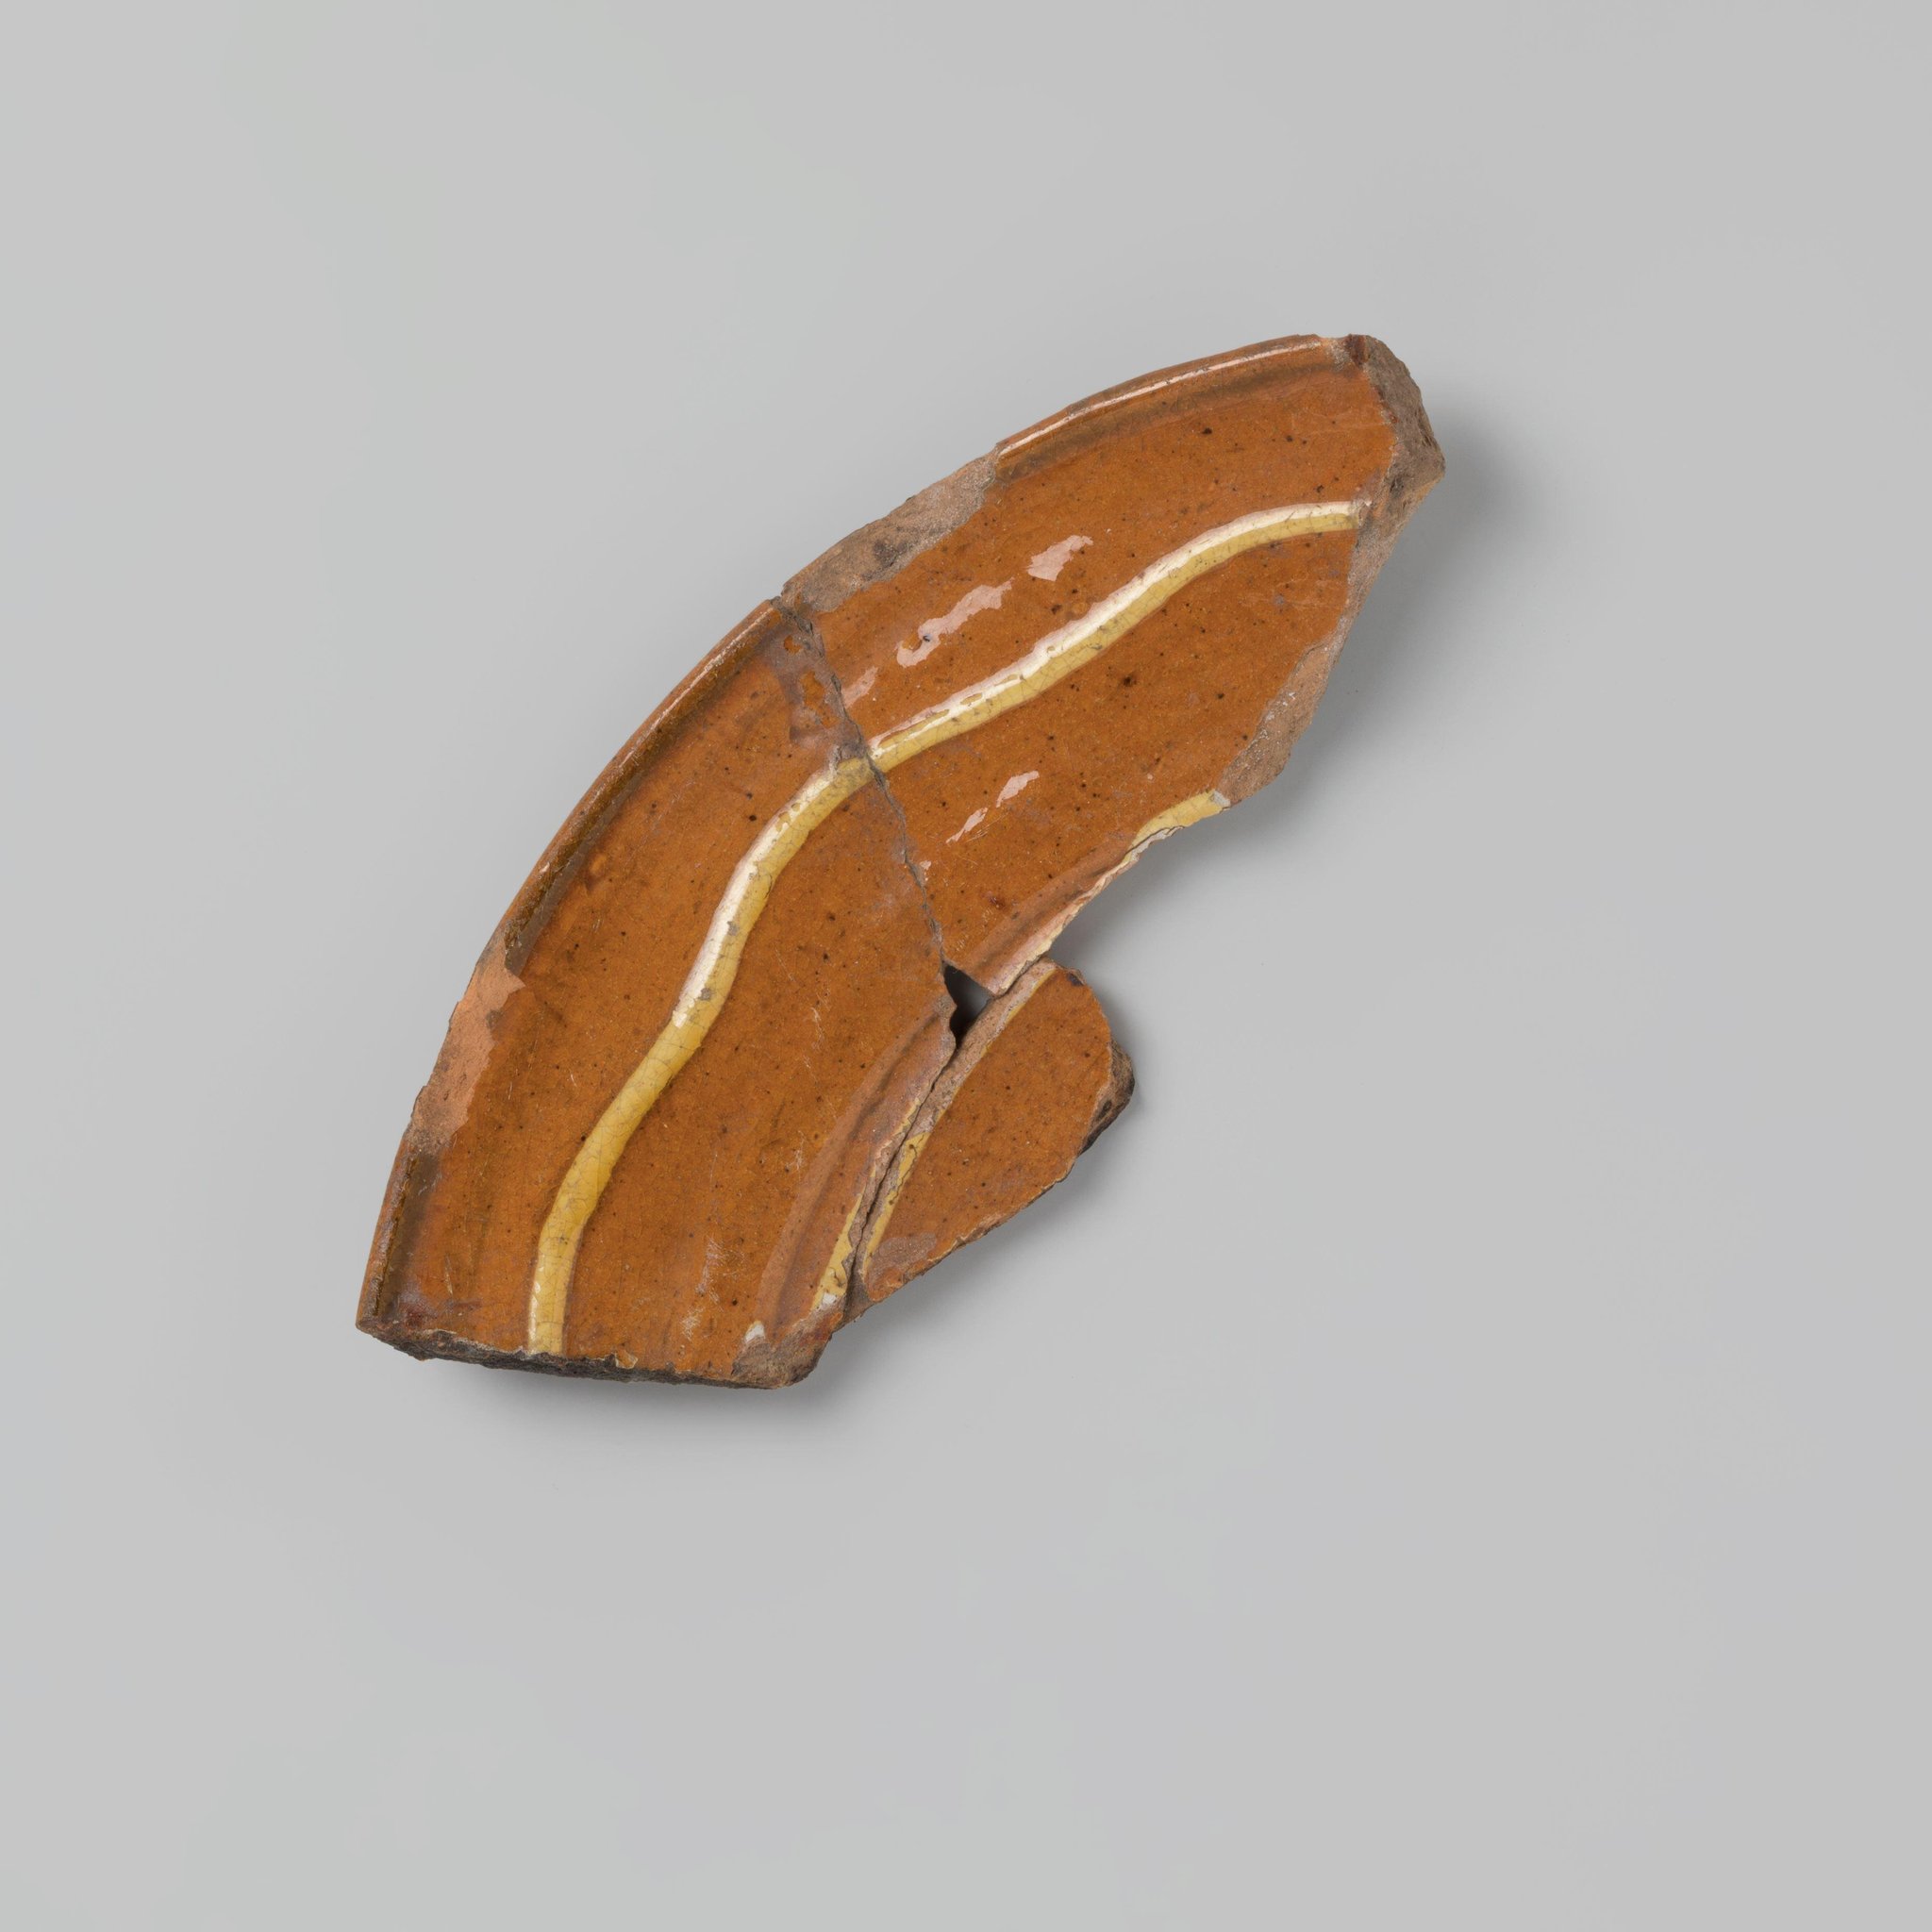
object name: sherd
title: Scherf van de rand van een schotel, van rood bakkend aardewerk voorzien van een golvende lijn in geel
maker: Anonymous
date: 1500-1799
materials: earthenware, glaze